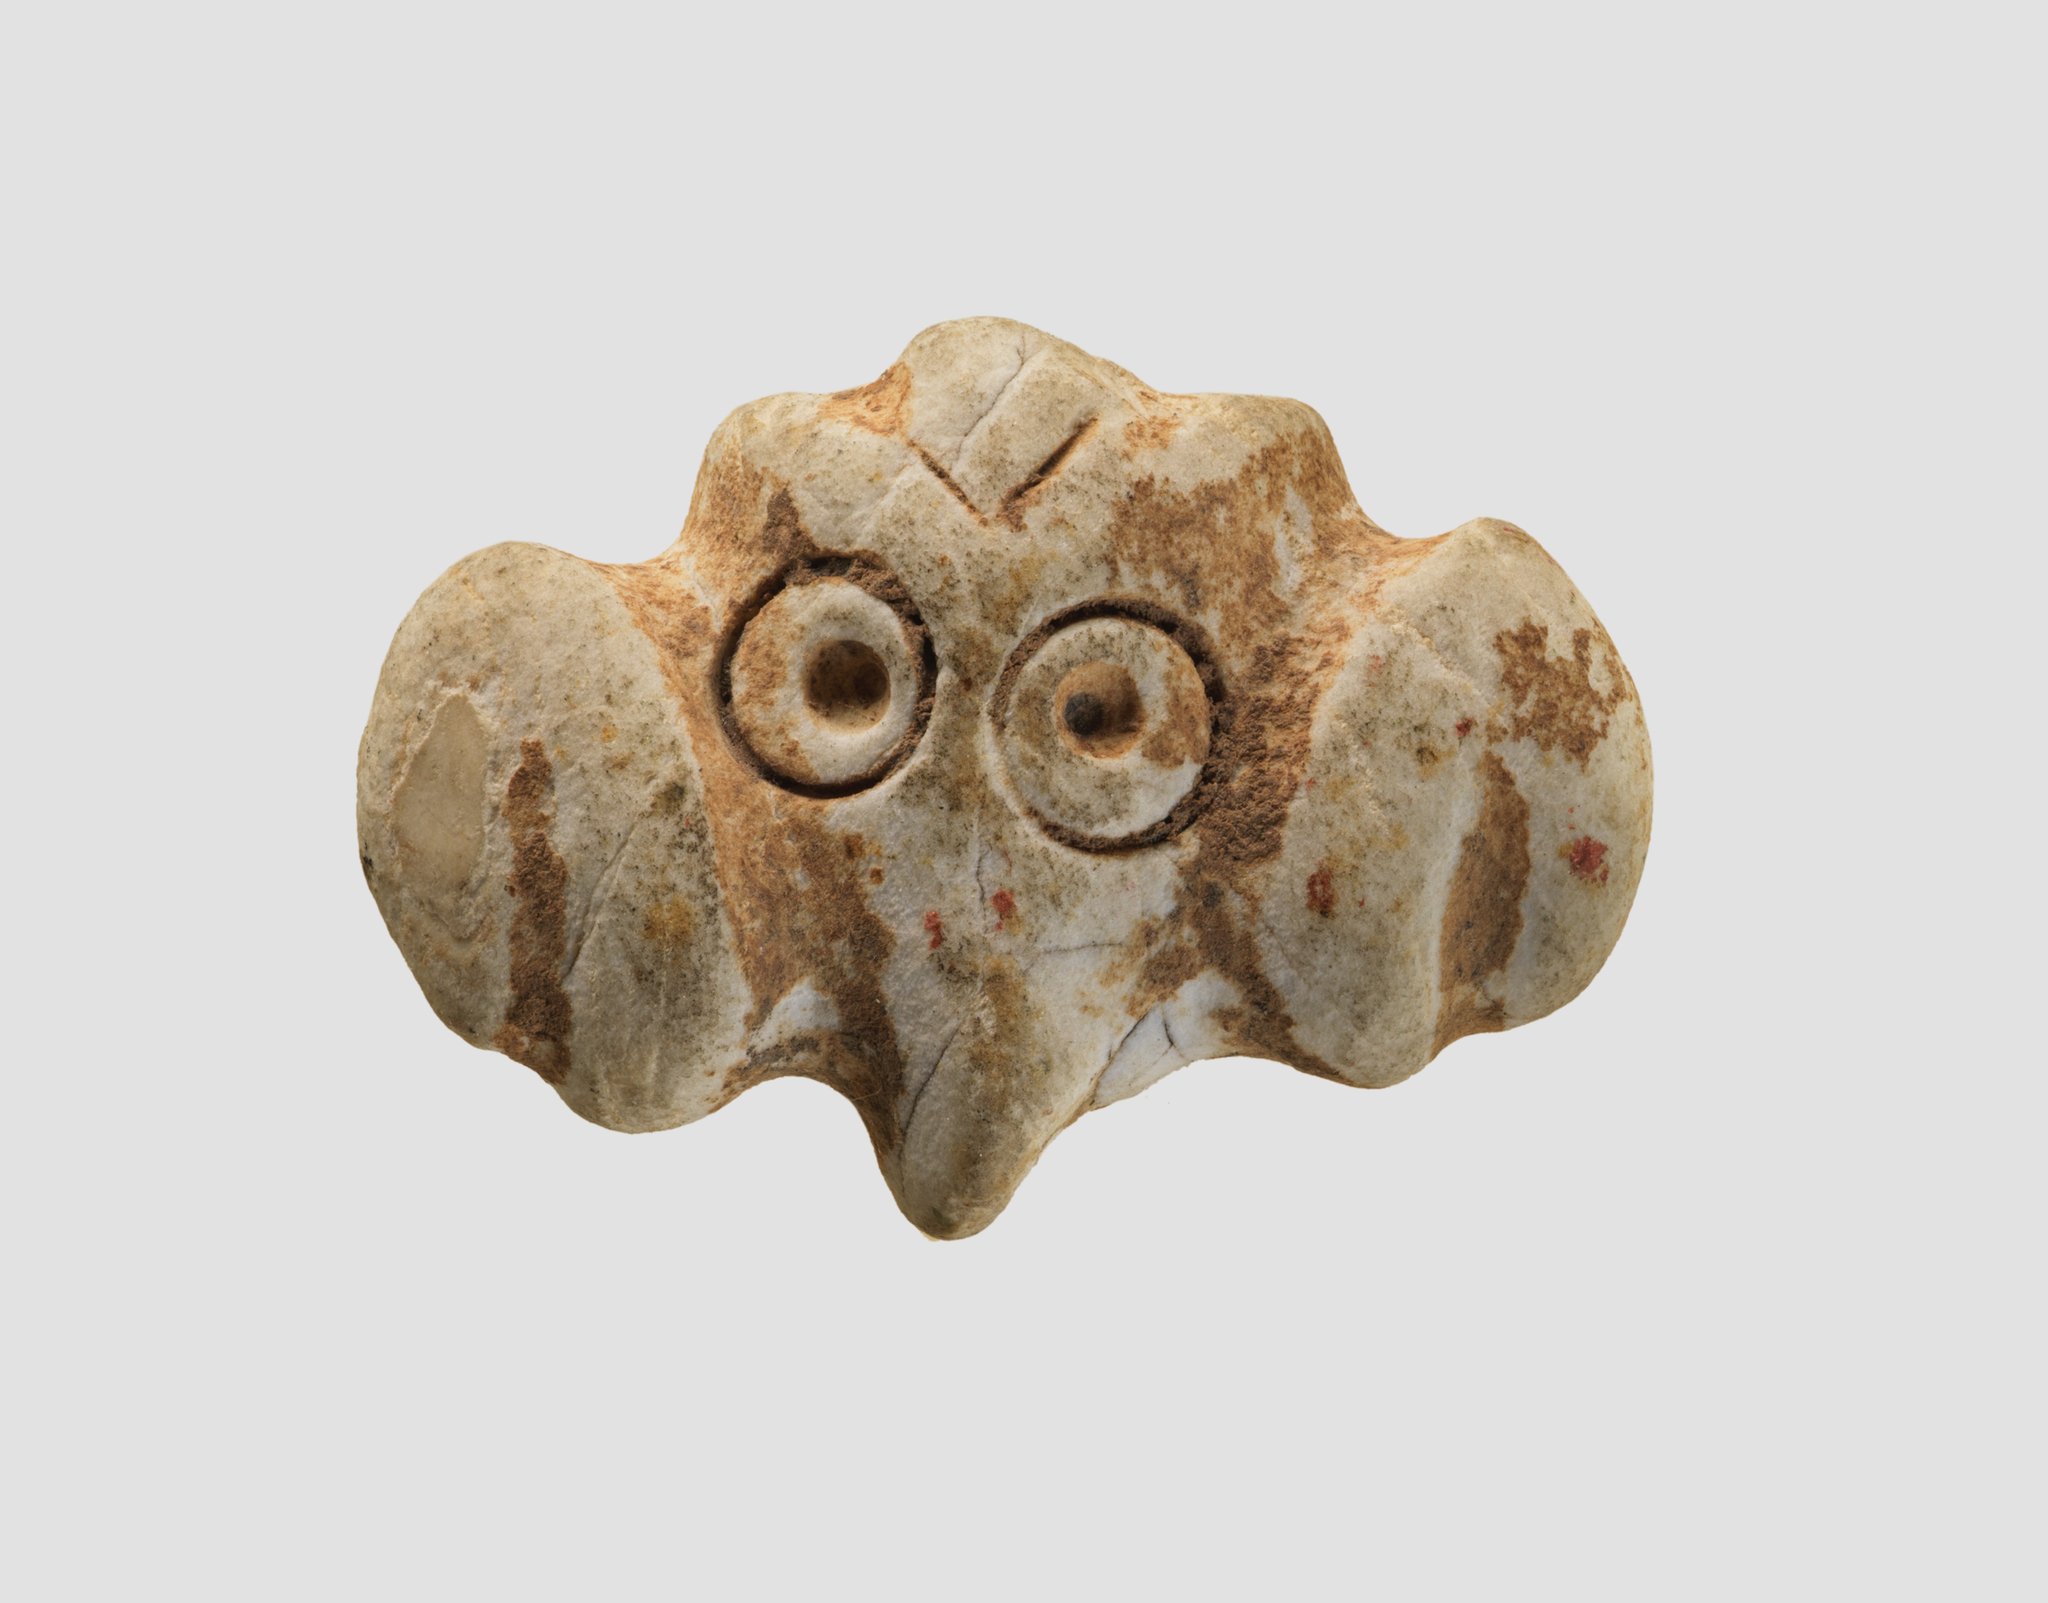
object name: necklace, bead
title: Amulet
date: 3000 BCE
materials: alabaster, gypsum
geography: iran